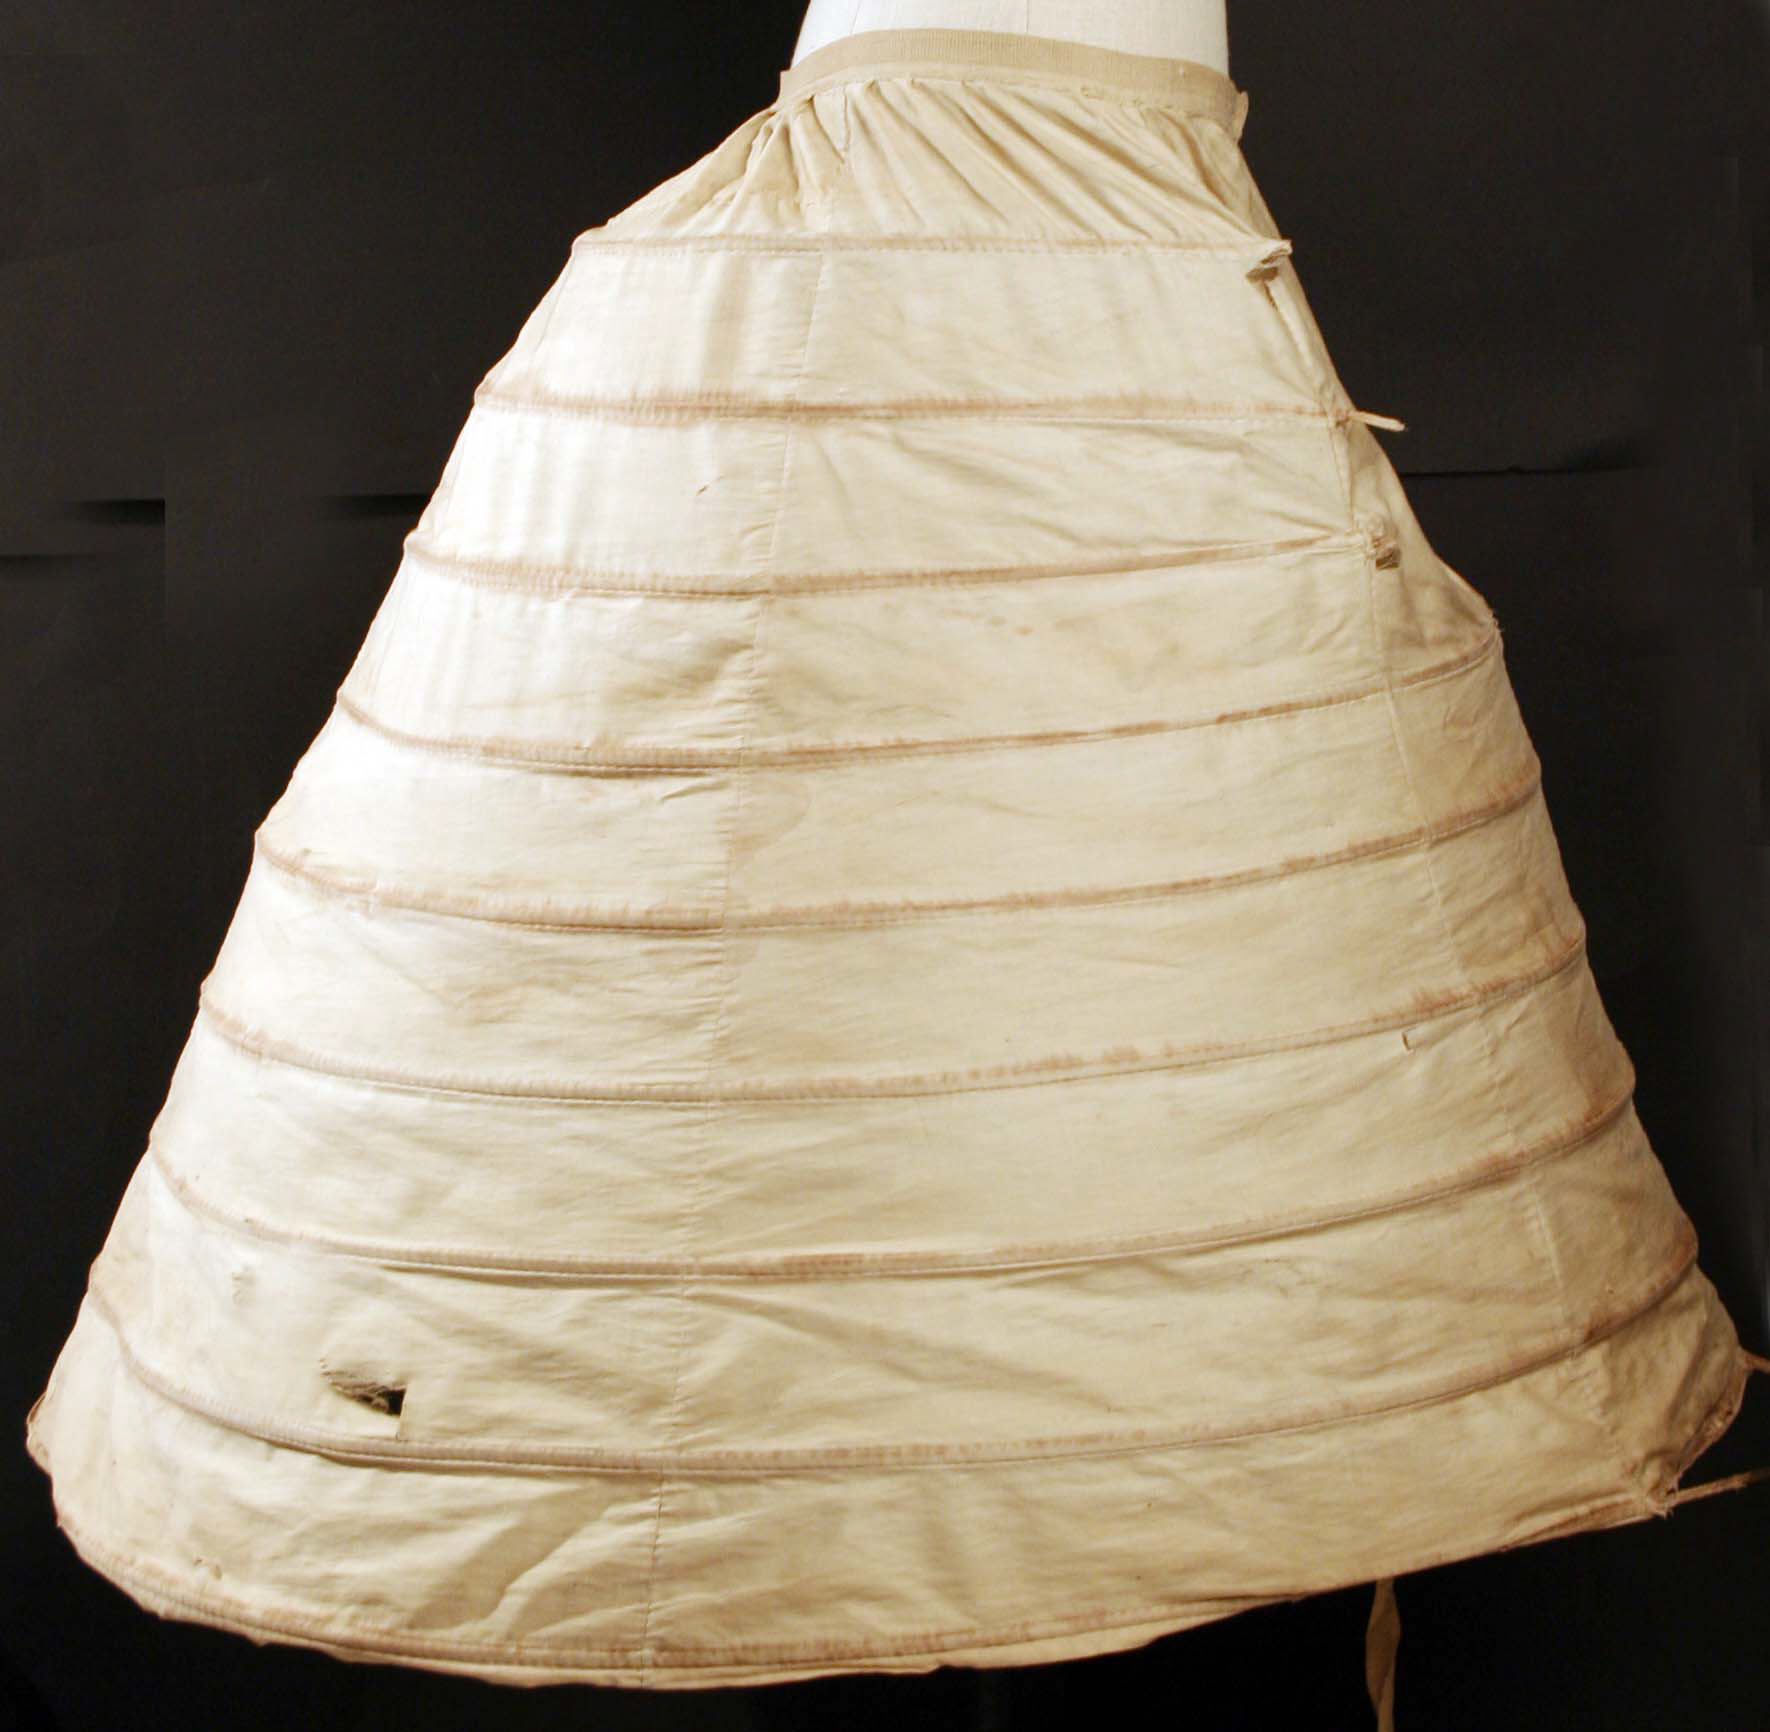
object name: cage crinoline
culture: american or european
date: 1834-1866